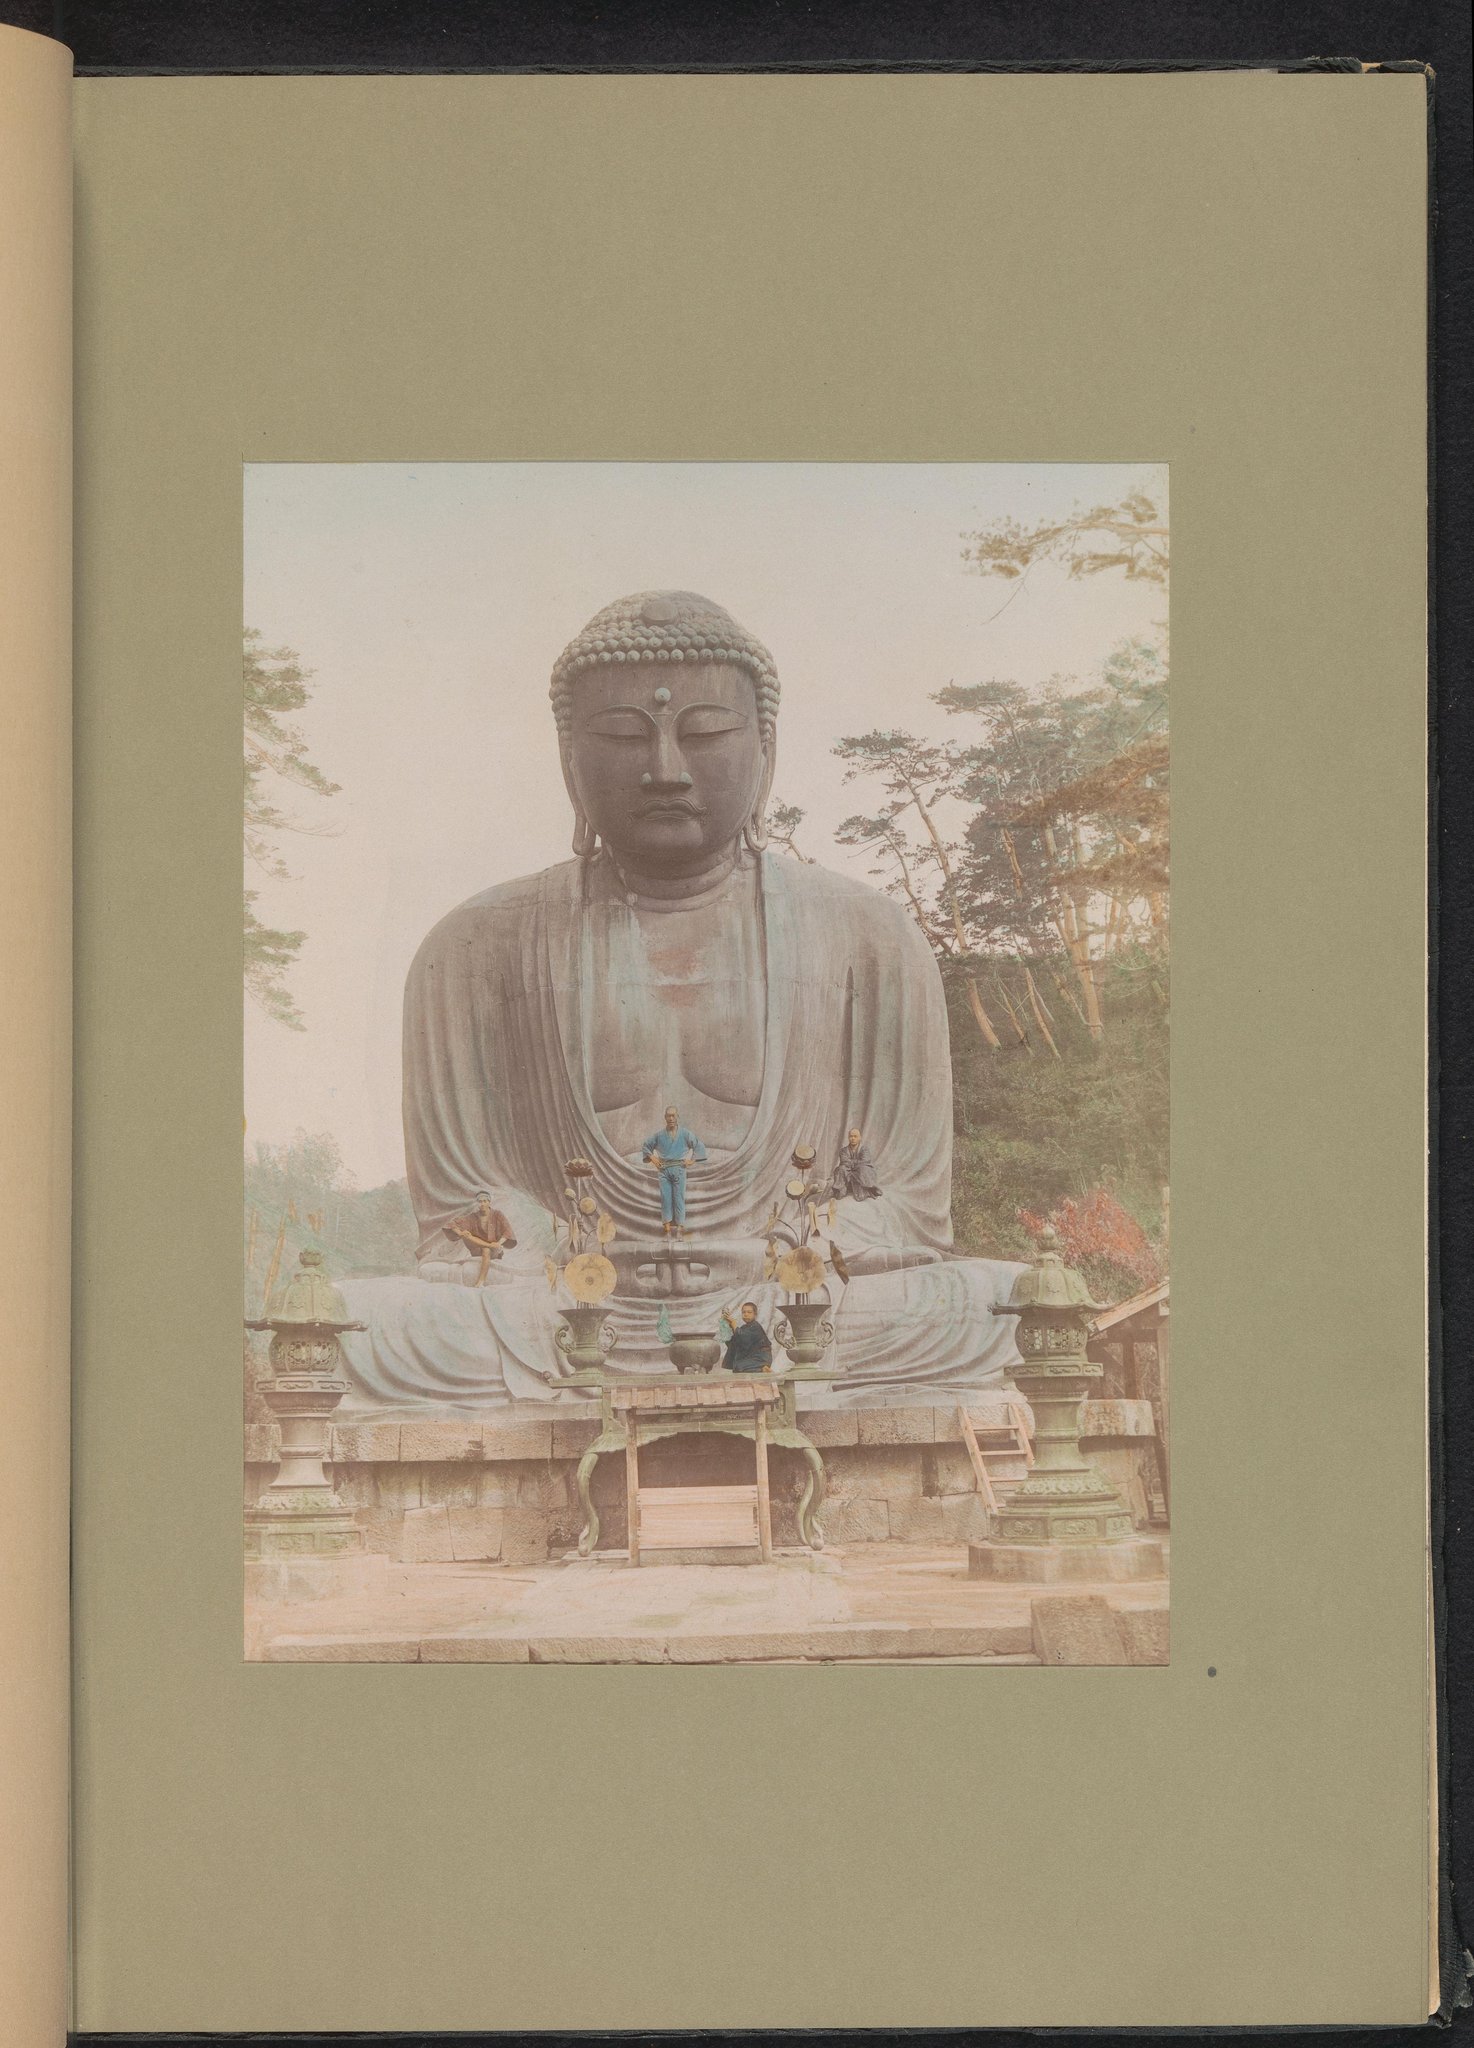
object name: photograph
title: Boeddhabeeld in de Kotoku-intempel te Kamakura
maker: Anonymous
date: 1887-1897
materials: photographic support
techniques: albumen print, hand coloring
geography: kamakura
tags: sculpture, buddha, founder of buddhism